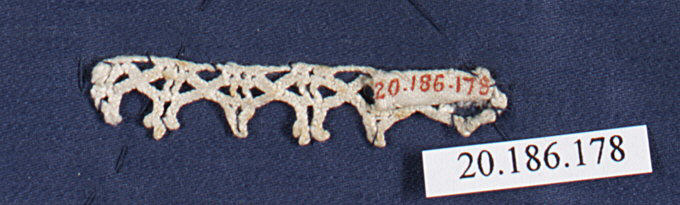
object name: edging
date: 1501-1600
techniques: lace